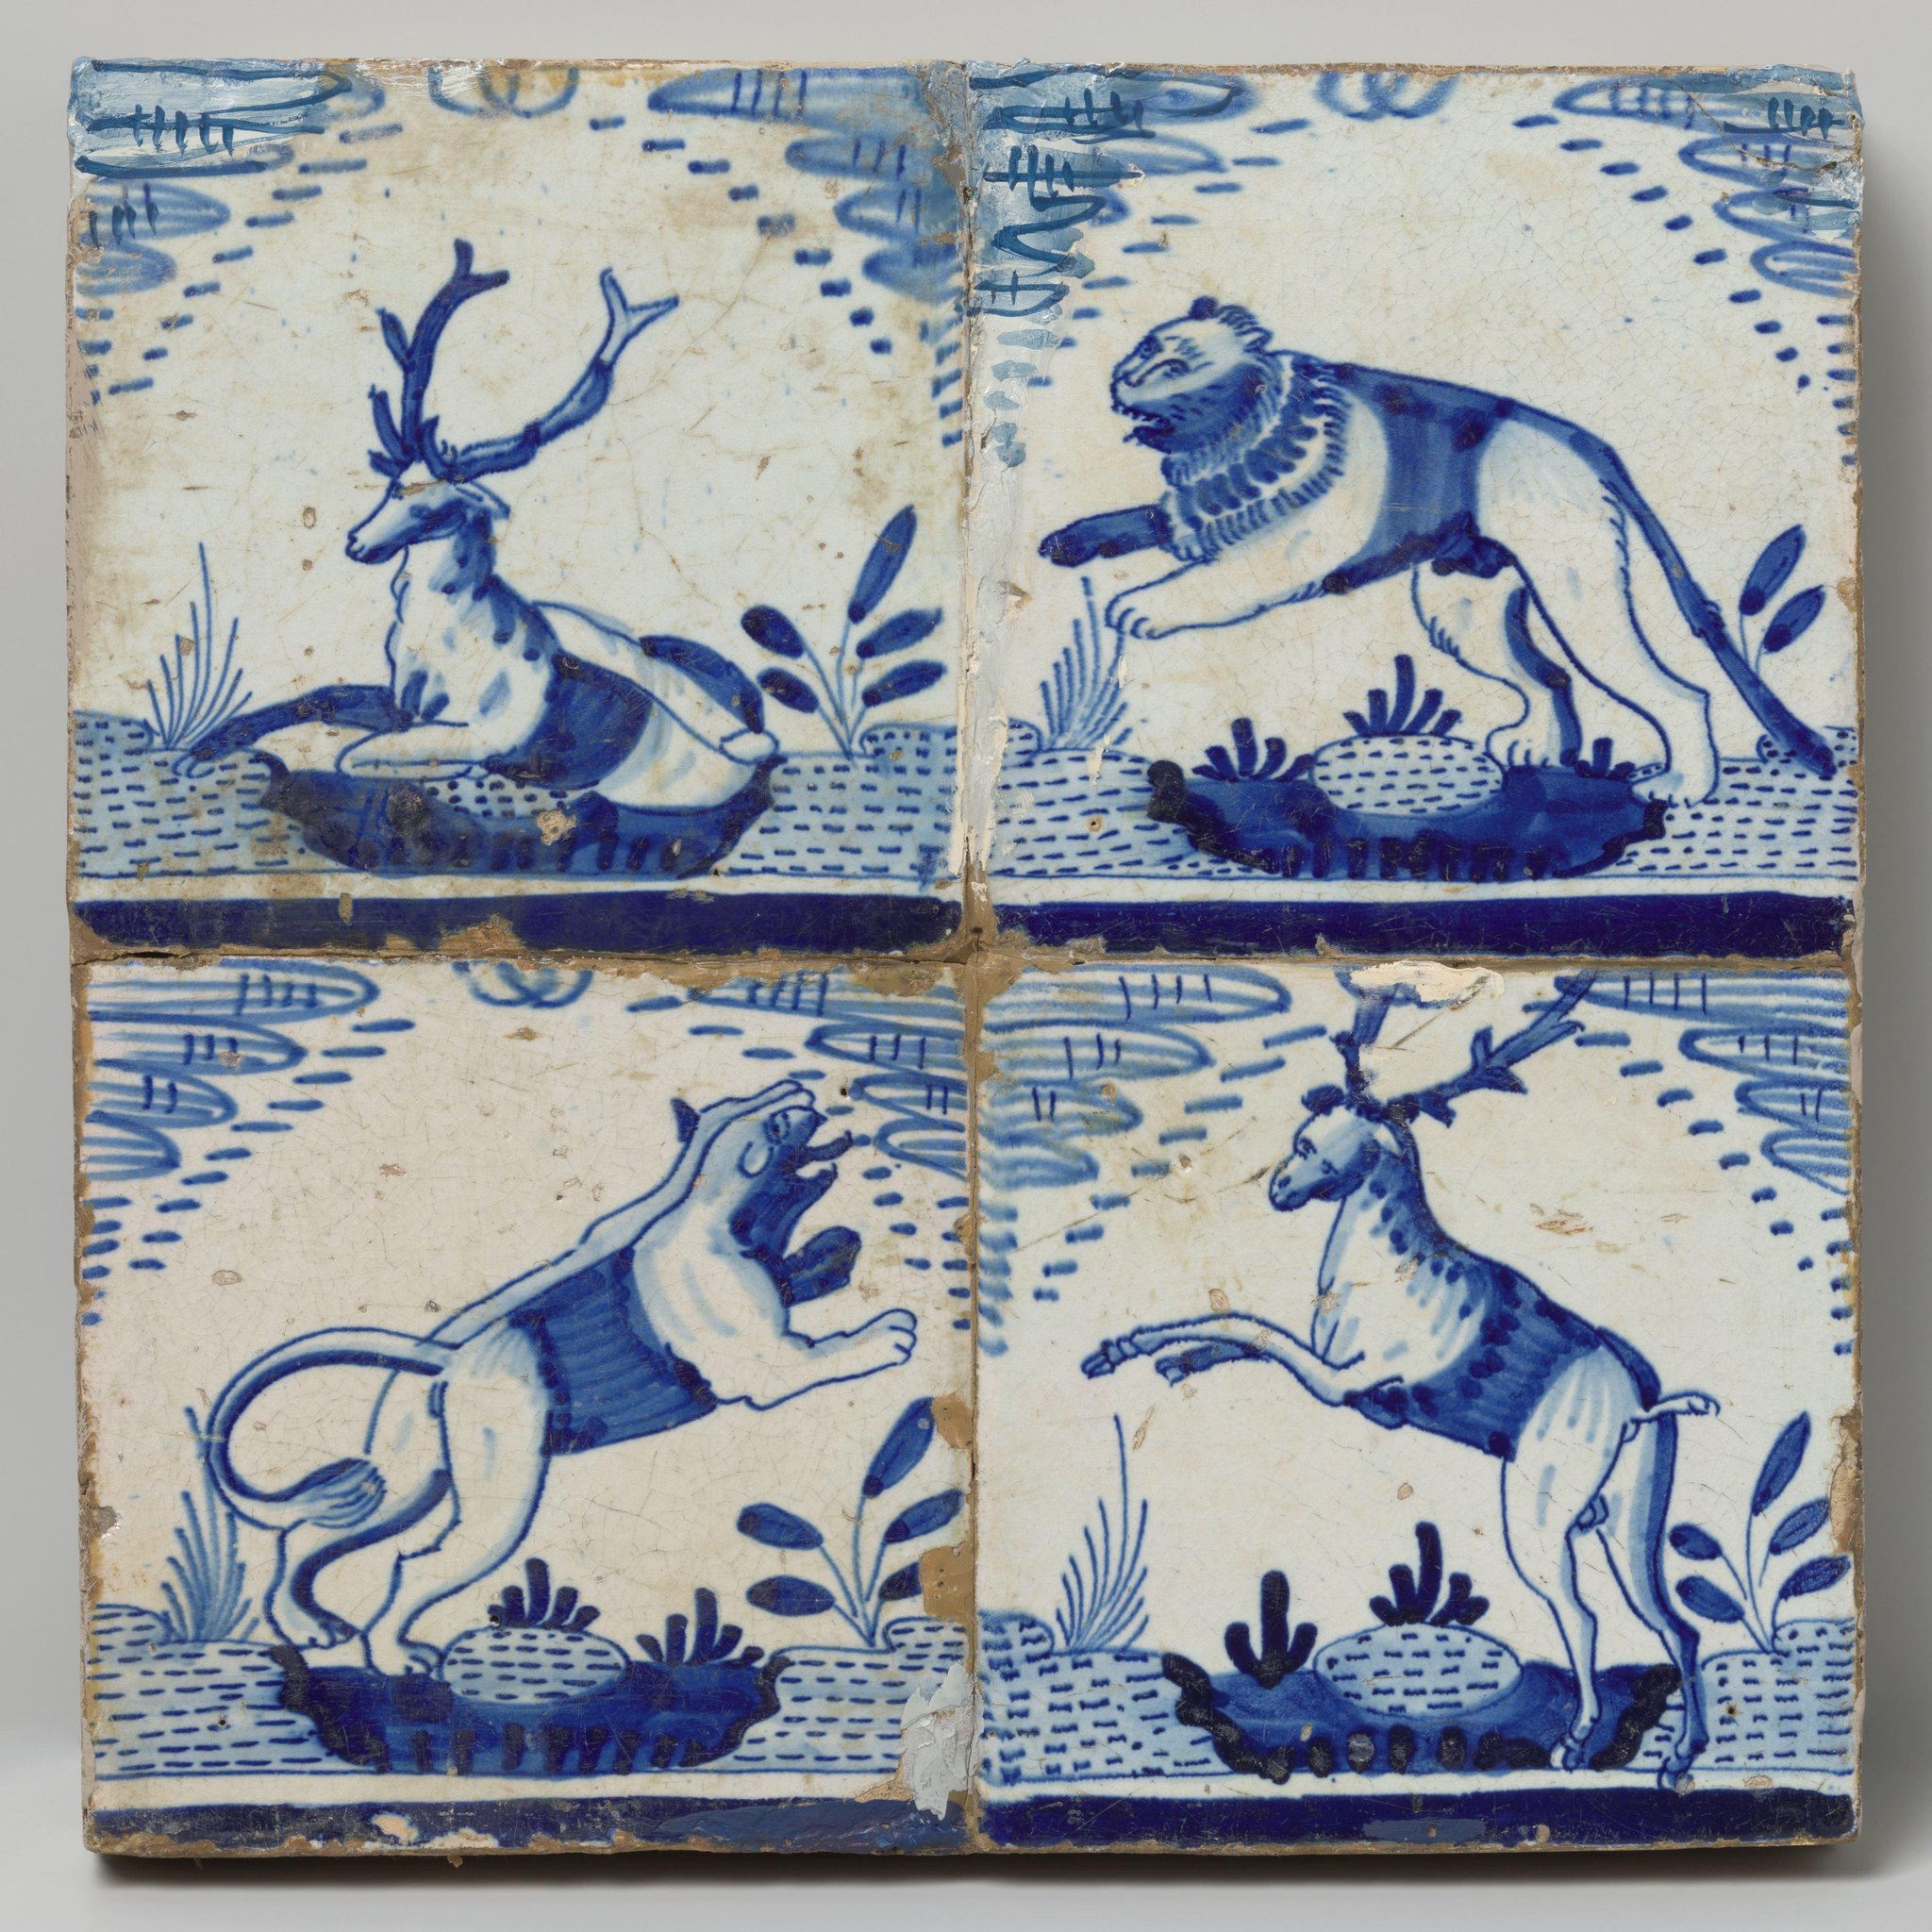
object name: diertegel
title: Veld van vier diertegels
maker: Anonymous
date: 1620-1640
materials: earthenware, glaze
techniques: maiolica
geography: netherlands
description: Veld van vier diertegels (2 x 2) elk met een blauw geschilderd dier: hert of leeuw. Het dier is omgeven door een koelpelvormige hemel van wolkjes en streepjes.